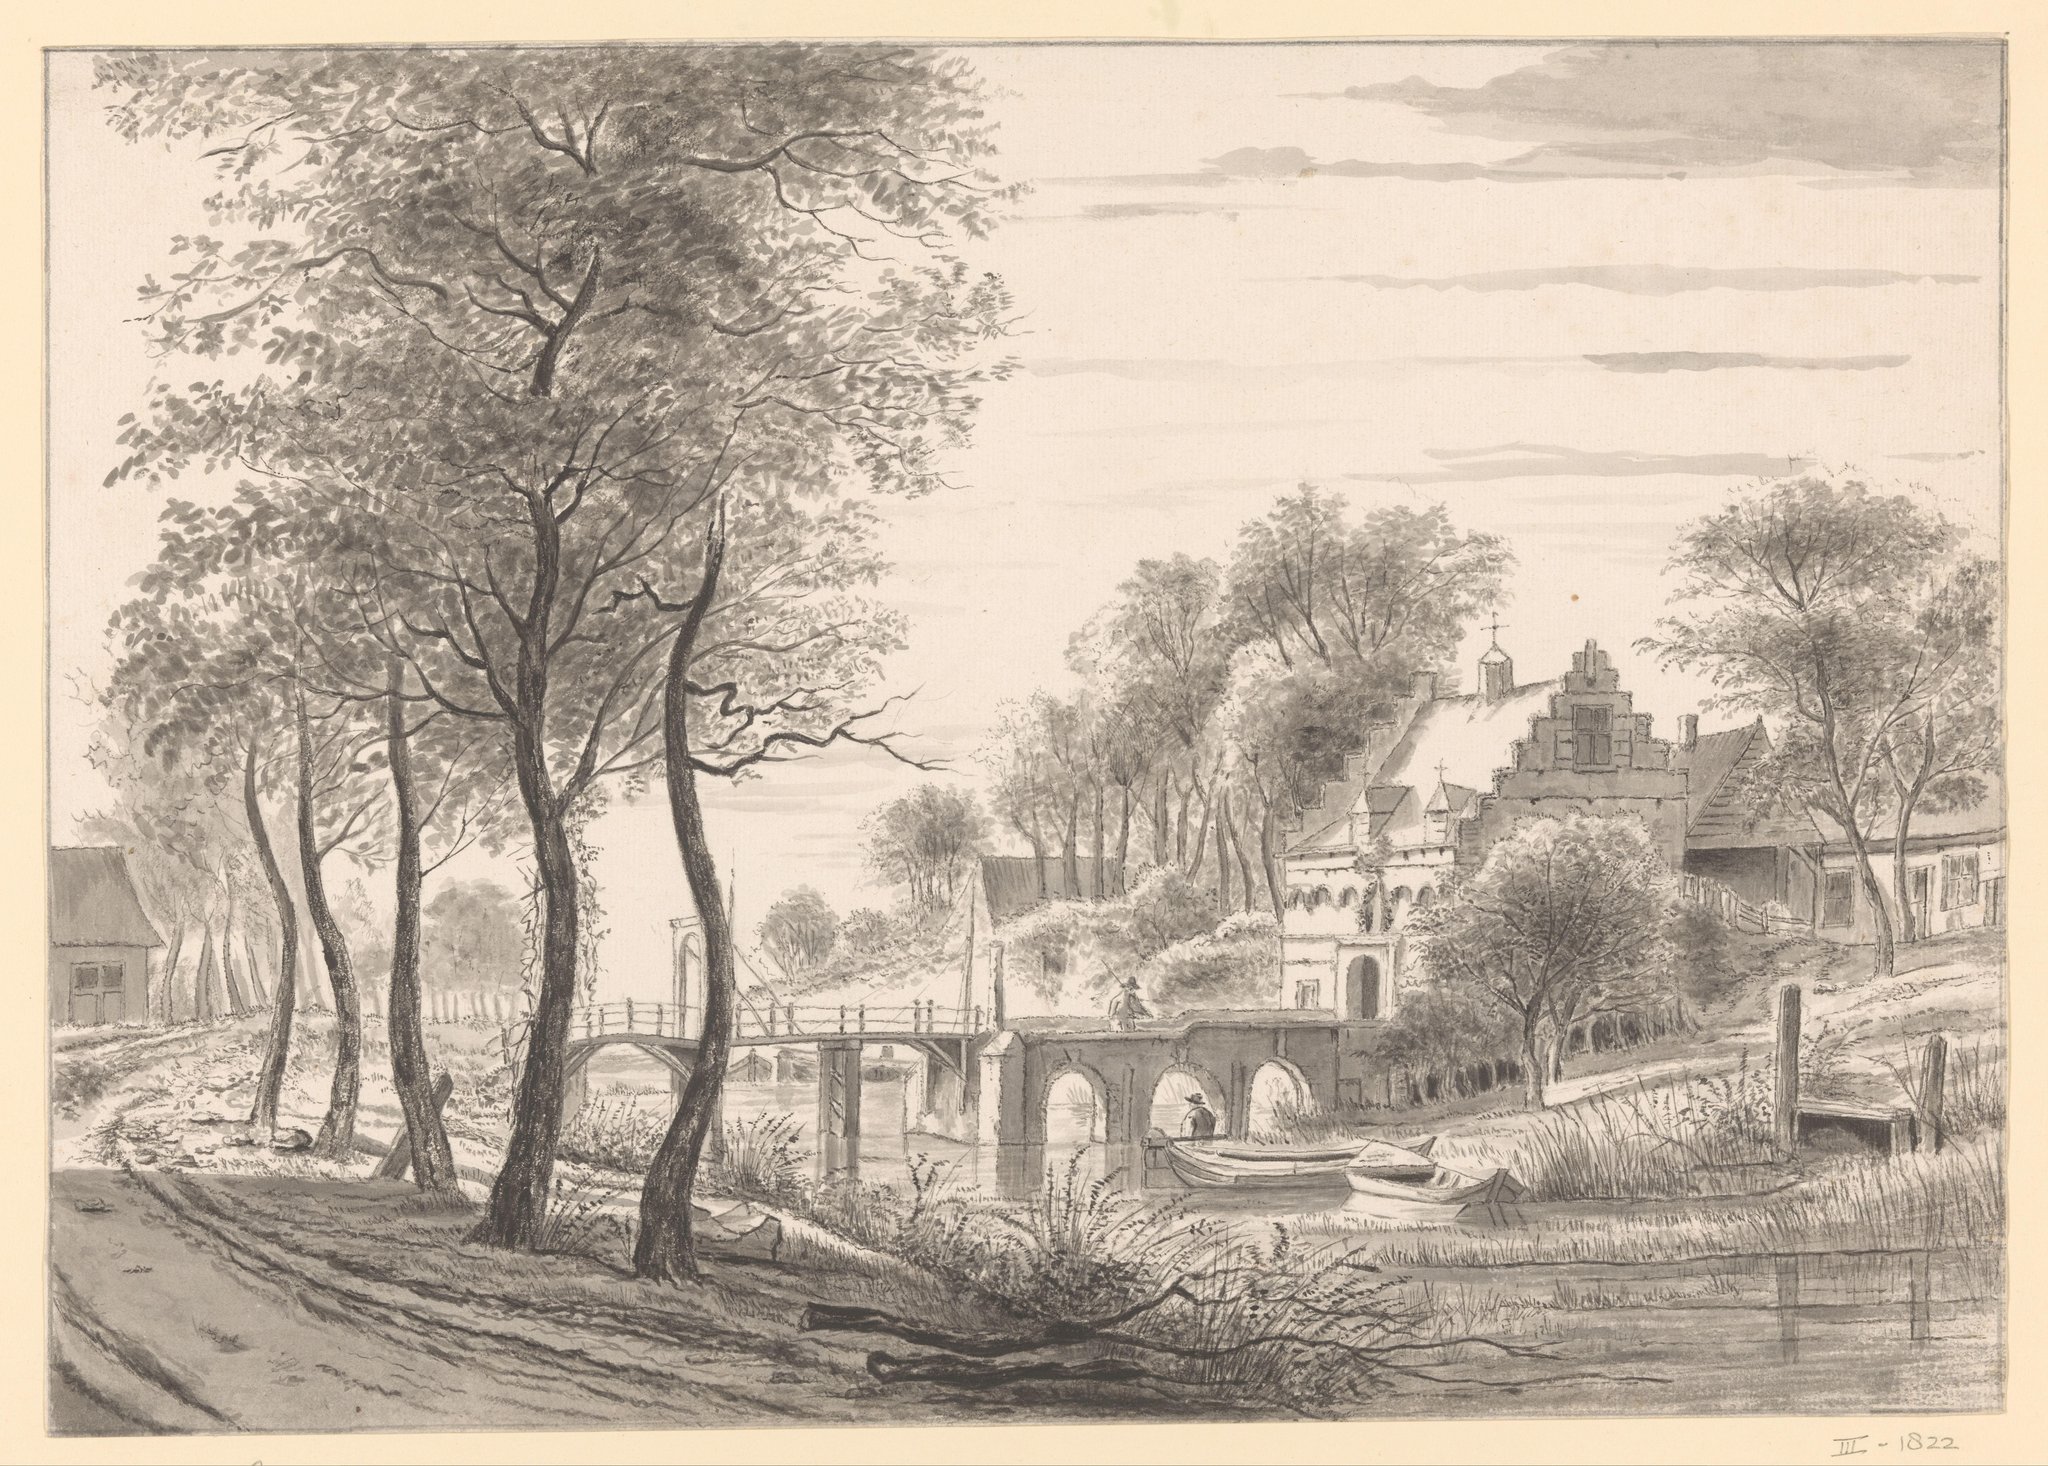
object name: drawing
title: Gezicht op de voorpoort van Kasteel Buren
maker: Anonymous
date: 1803-1822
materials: chalk, ink, paper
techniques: brush, pen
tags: bridge in village across river, canal, etc. - ii - ideal landscapes, canals, waters (in village), gate, entrance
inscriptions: inscription: ‘Maart 1822 FAVW De voorpoort Brug van 't Slot te Buuren’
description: Gezicht op de voorpoort, die in 1883 werd gesloopt. Het kasteel zelf was al in 1804 afgebroken.